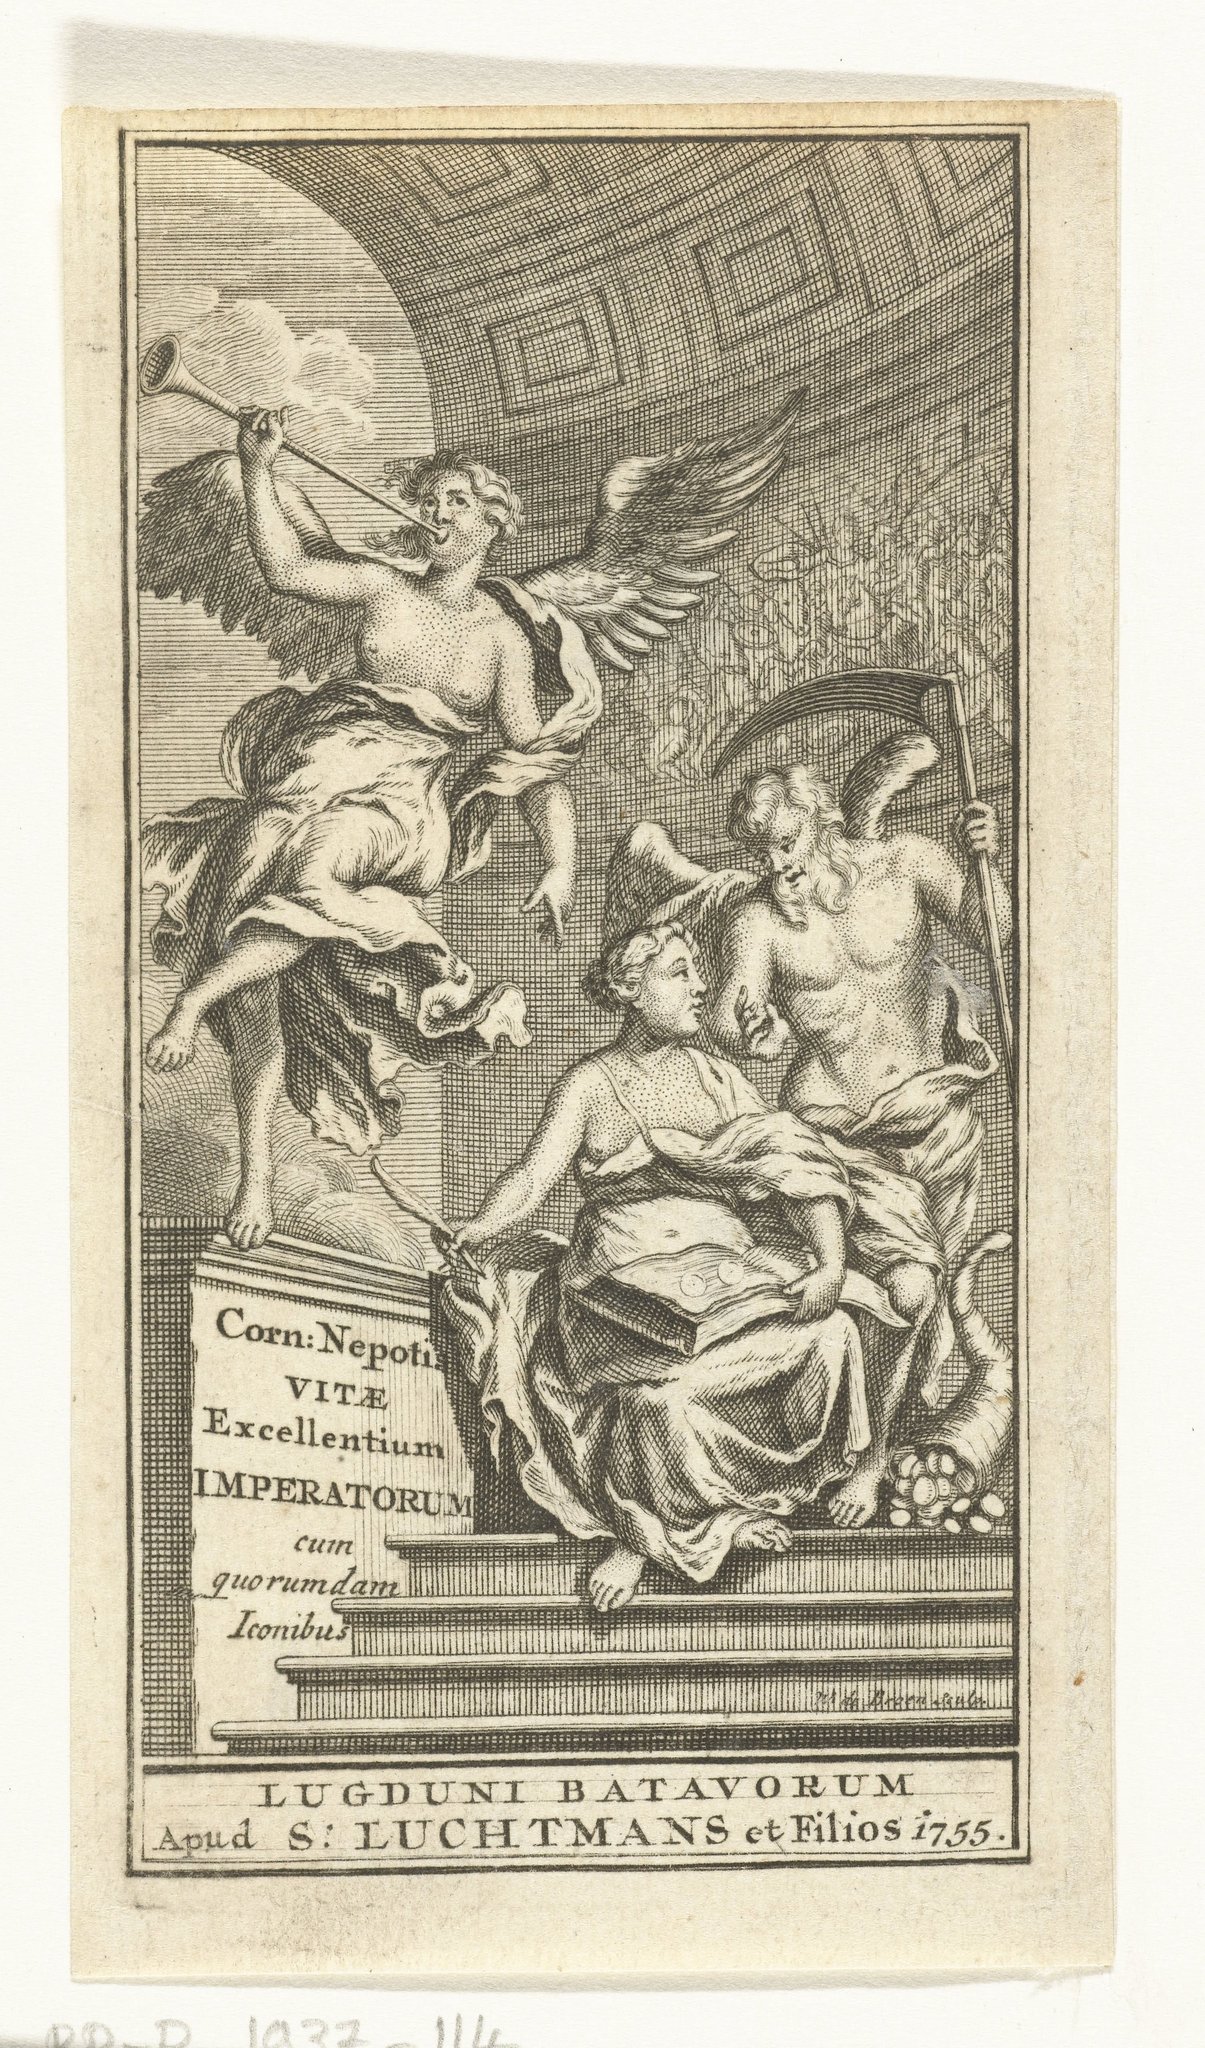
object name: titelblad, titelpagina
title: Gesprek tussen Tijd en Geschiedschrijving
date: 1755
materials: paper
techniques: engraving, etching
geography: leiden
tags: 'historia'; 'historia' (ripa), father time, man with wings and scythe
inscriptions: collector's mark: Lugt 2228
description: De personificaties van Tijd en Geschiedschrijving zijn in gesprek met elkaar. Geschiedschrijving zit op een trap in een grote hal. Naast haar een dansende engel die op een bazuin blaast.